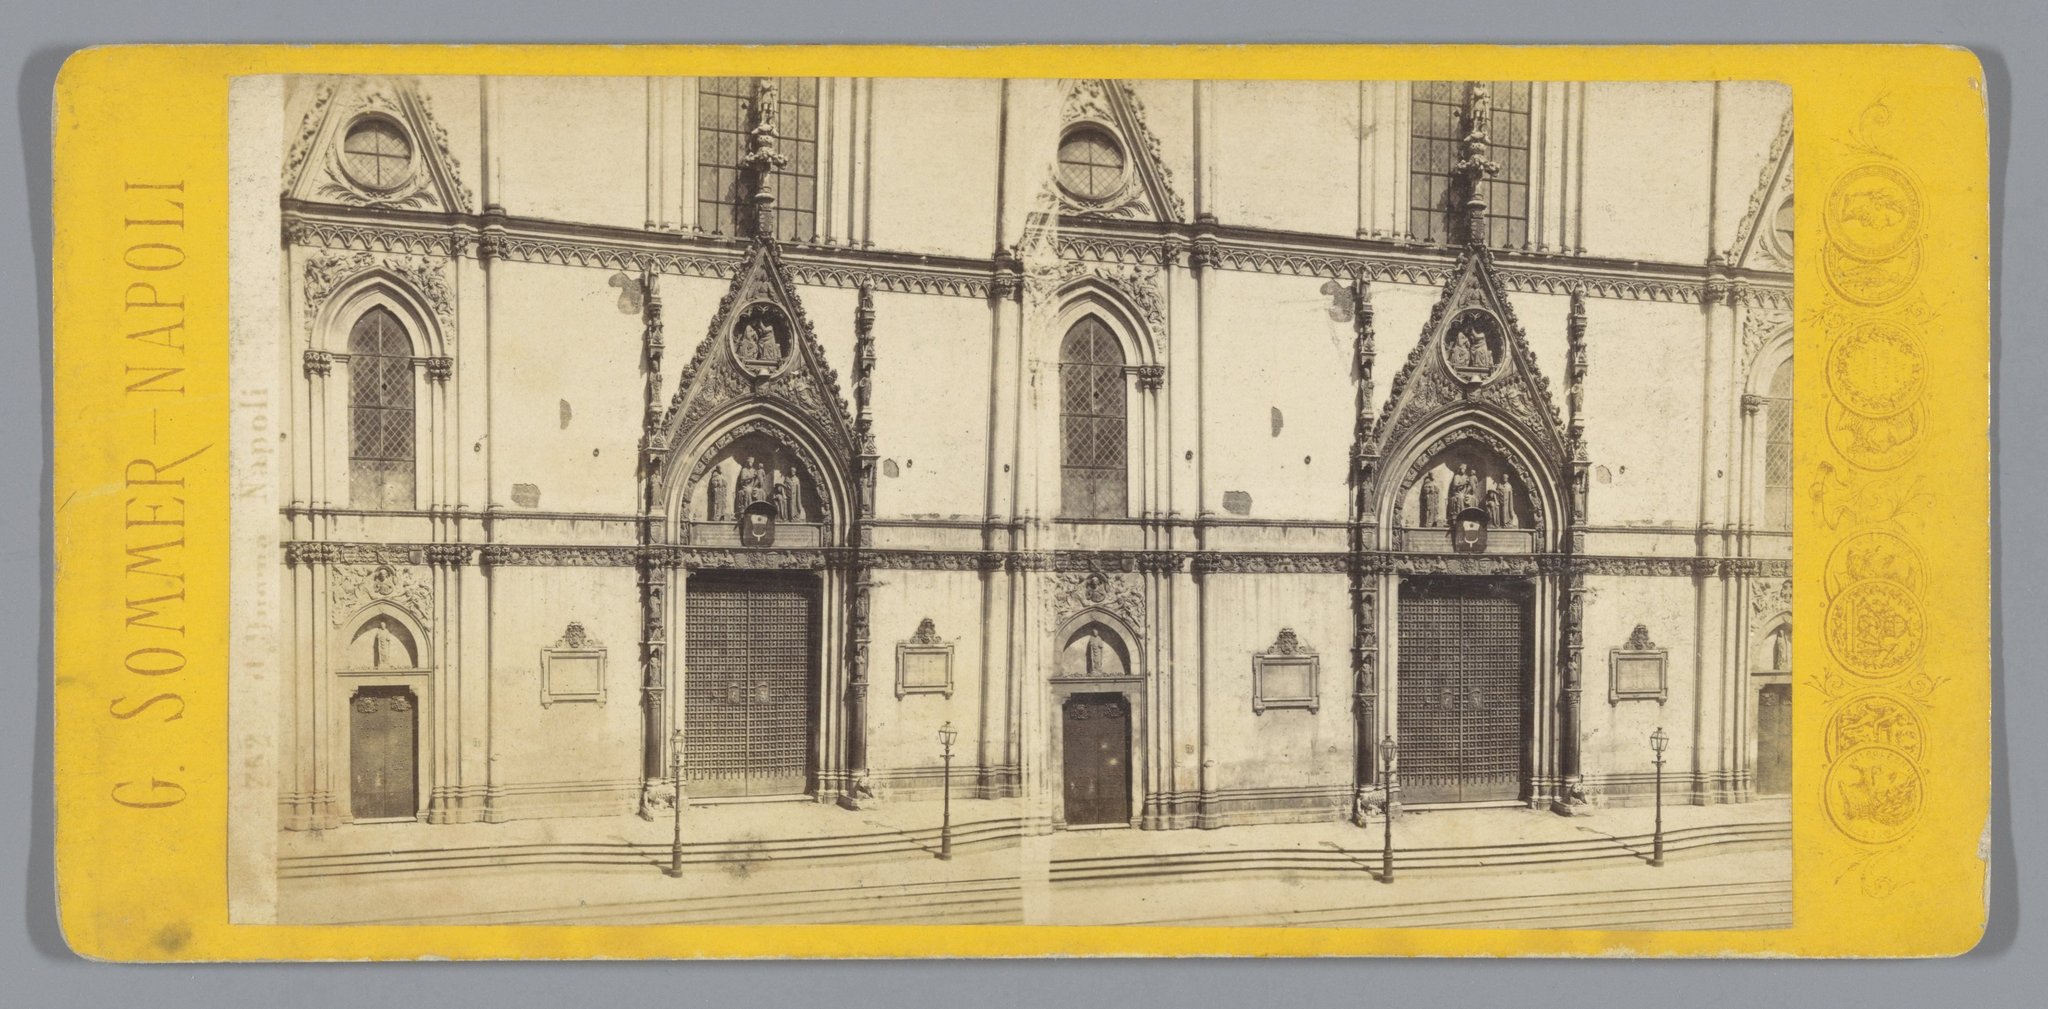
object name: stereograph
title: Il Duomo Napoli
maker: giorgio sommer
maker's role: fotograaf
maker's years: 1834-1914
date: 1860-1880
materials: cardboard, photographic support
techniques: albumen print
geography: naples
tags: parts of church exterior and annexes: portal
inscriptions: number: ‘752’, inscription: ‘Napels : Dom’